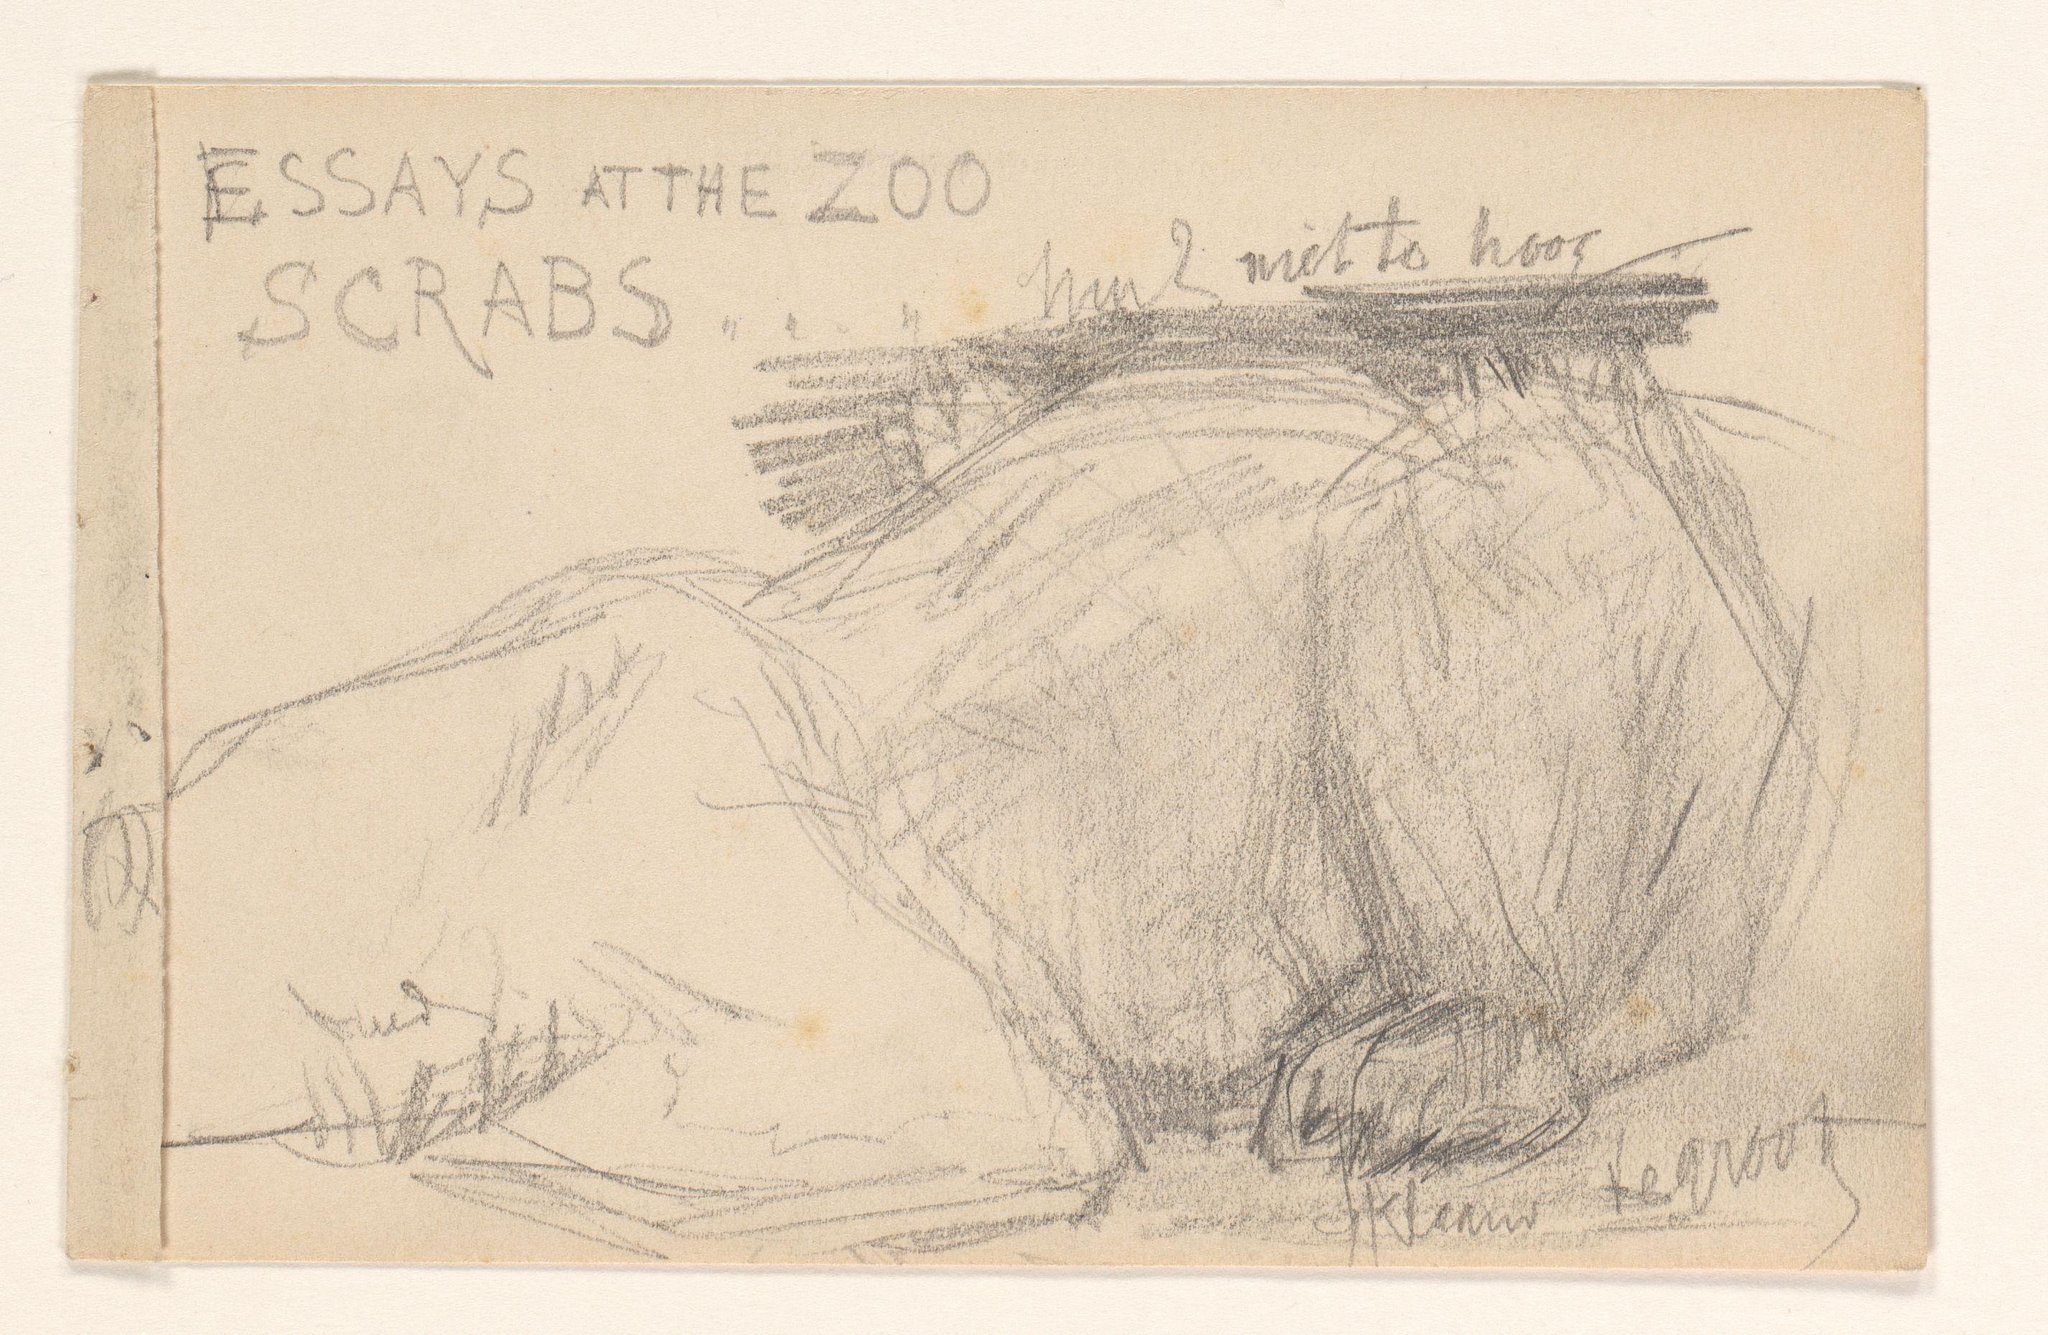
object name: drawing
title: Schets van een liggend dier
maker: august allebé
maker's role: draughtsman, print maker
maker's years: 1838-1927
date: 1848-1927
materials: paper, pencil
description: Schets van een liggend dier, met opschrift: Essays at the Zoo Scrabs.